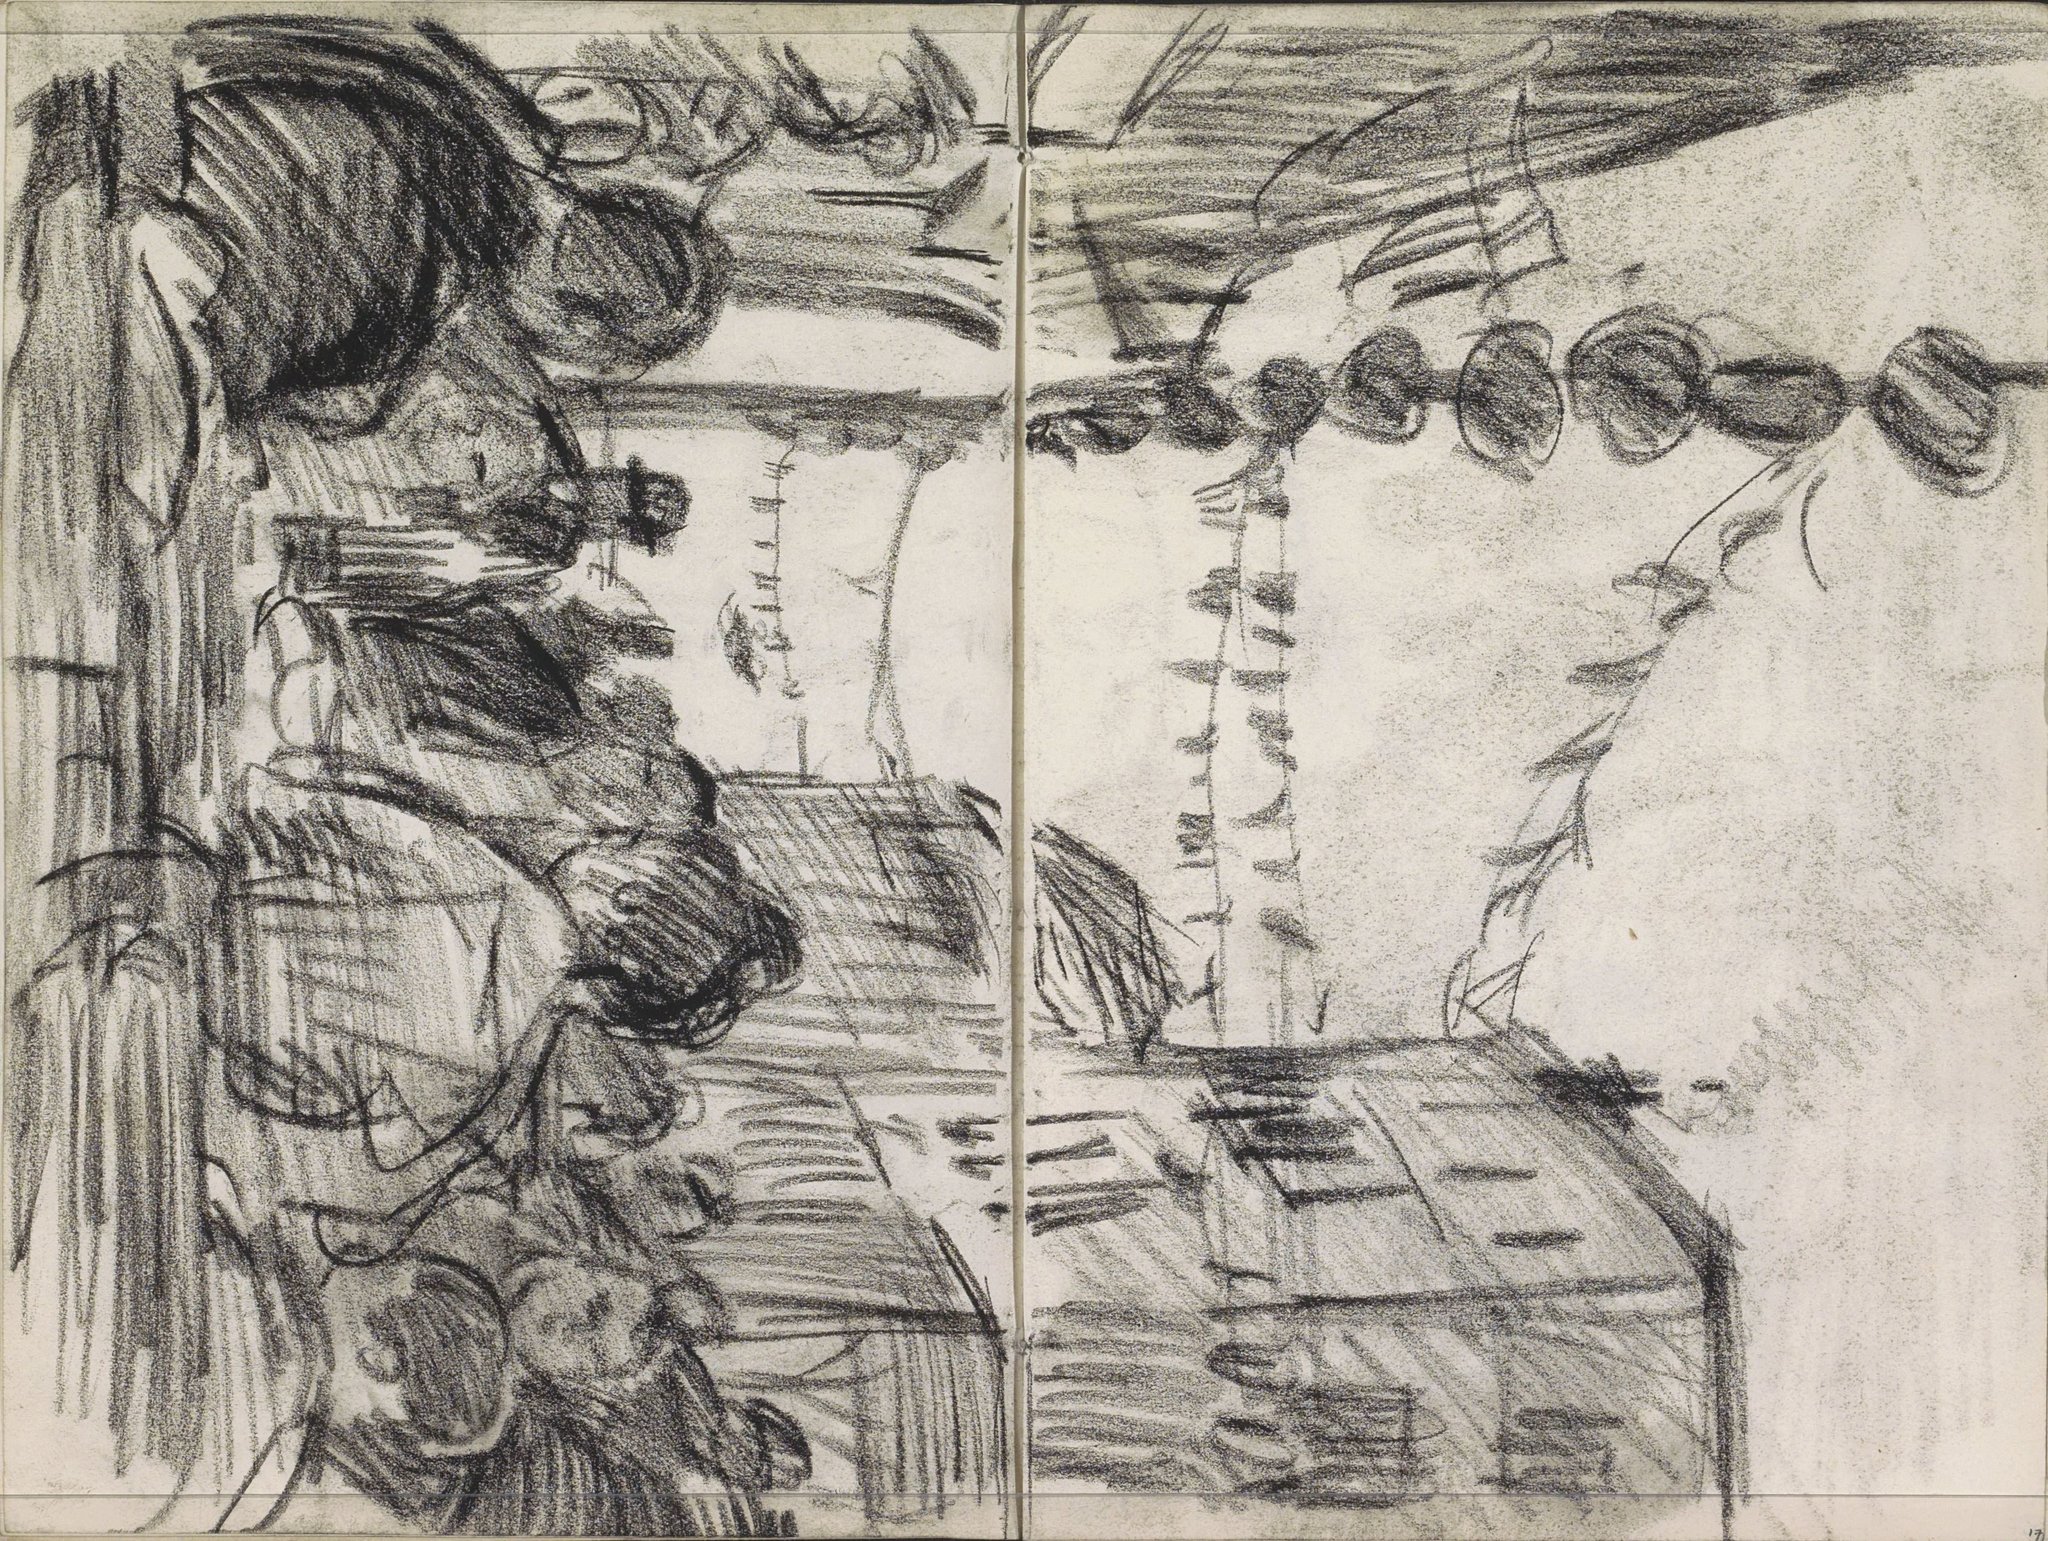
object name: sketchbook leaf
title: Straatfeest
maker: isaac israels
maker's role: draughtsman, painter, print maker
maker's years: 1865-1934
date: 1875-1934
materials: chalk, paper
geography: paris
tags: decoration and illumination of streets, squares, etc. (~ triumphal entry, etc.), festivities, street (+ city(-scape) with figures, staffage), paris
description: Figuren zitten aan lange tafels op straat. Op de tafels eten en drank. De straat is versierd met vlaggen en lampionnen. Mogelijk in Parijs. Blad 16 verso en blad 17 recto uit schetsboek L met 42 bladen.